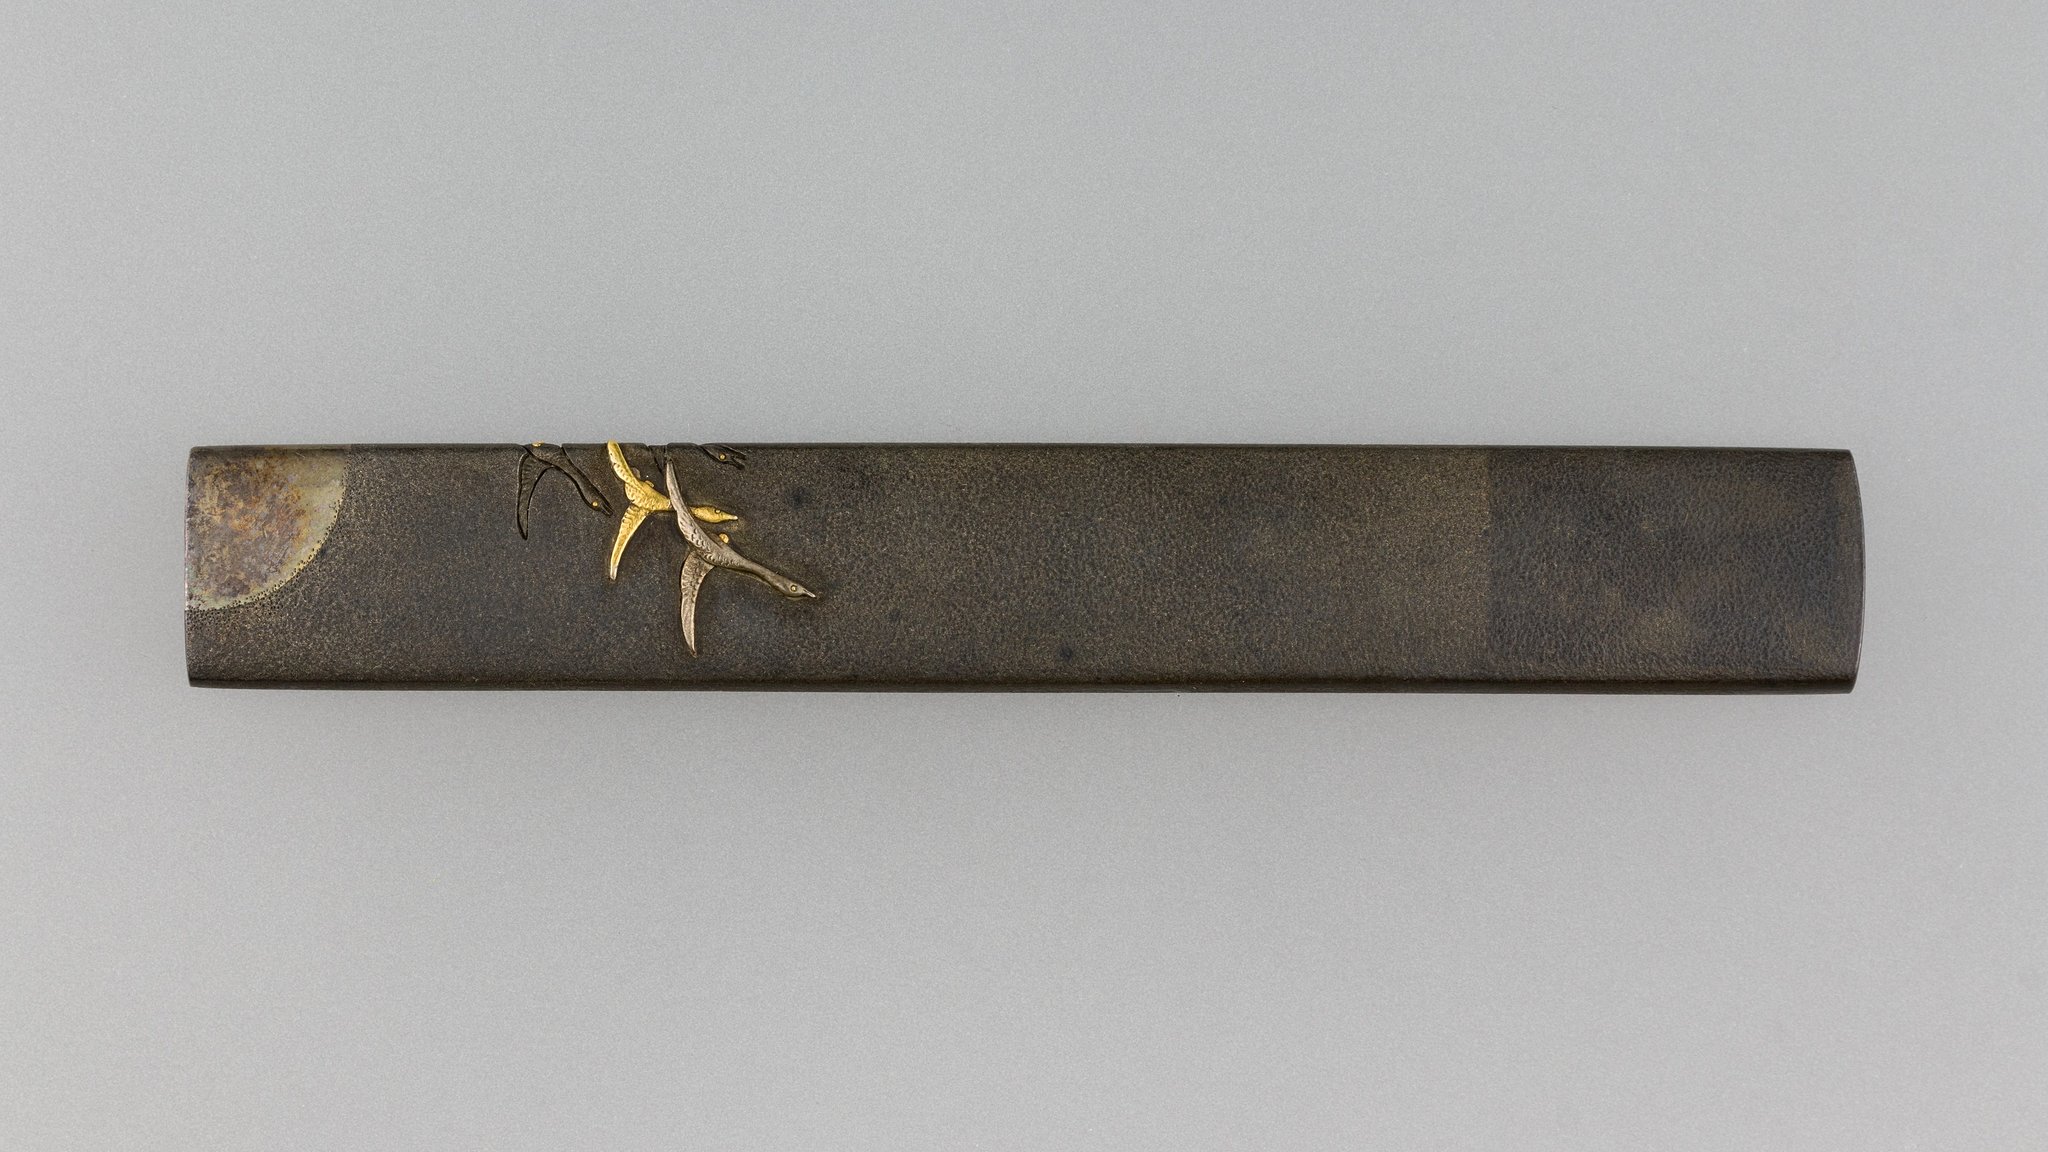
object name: knife handle kozuka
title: Knife Handle (Kozuka)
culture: japanese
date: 1770-1852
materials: silver alloy, gold, silver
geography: japan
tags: birds